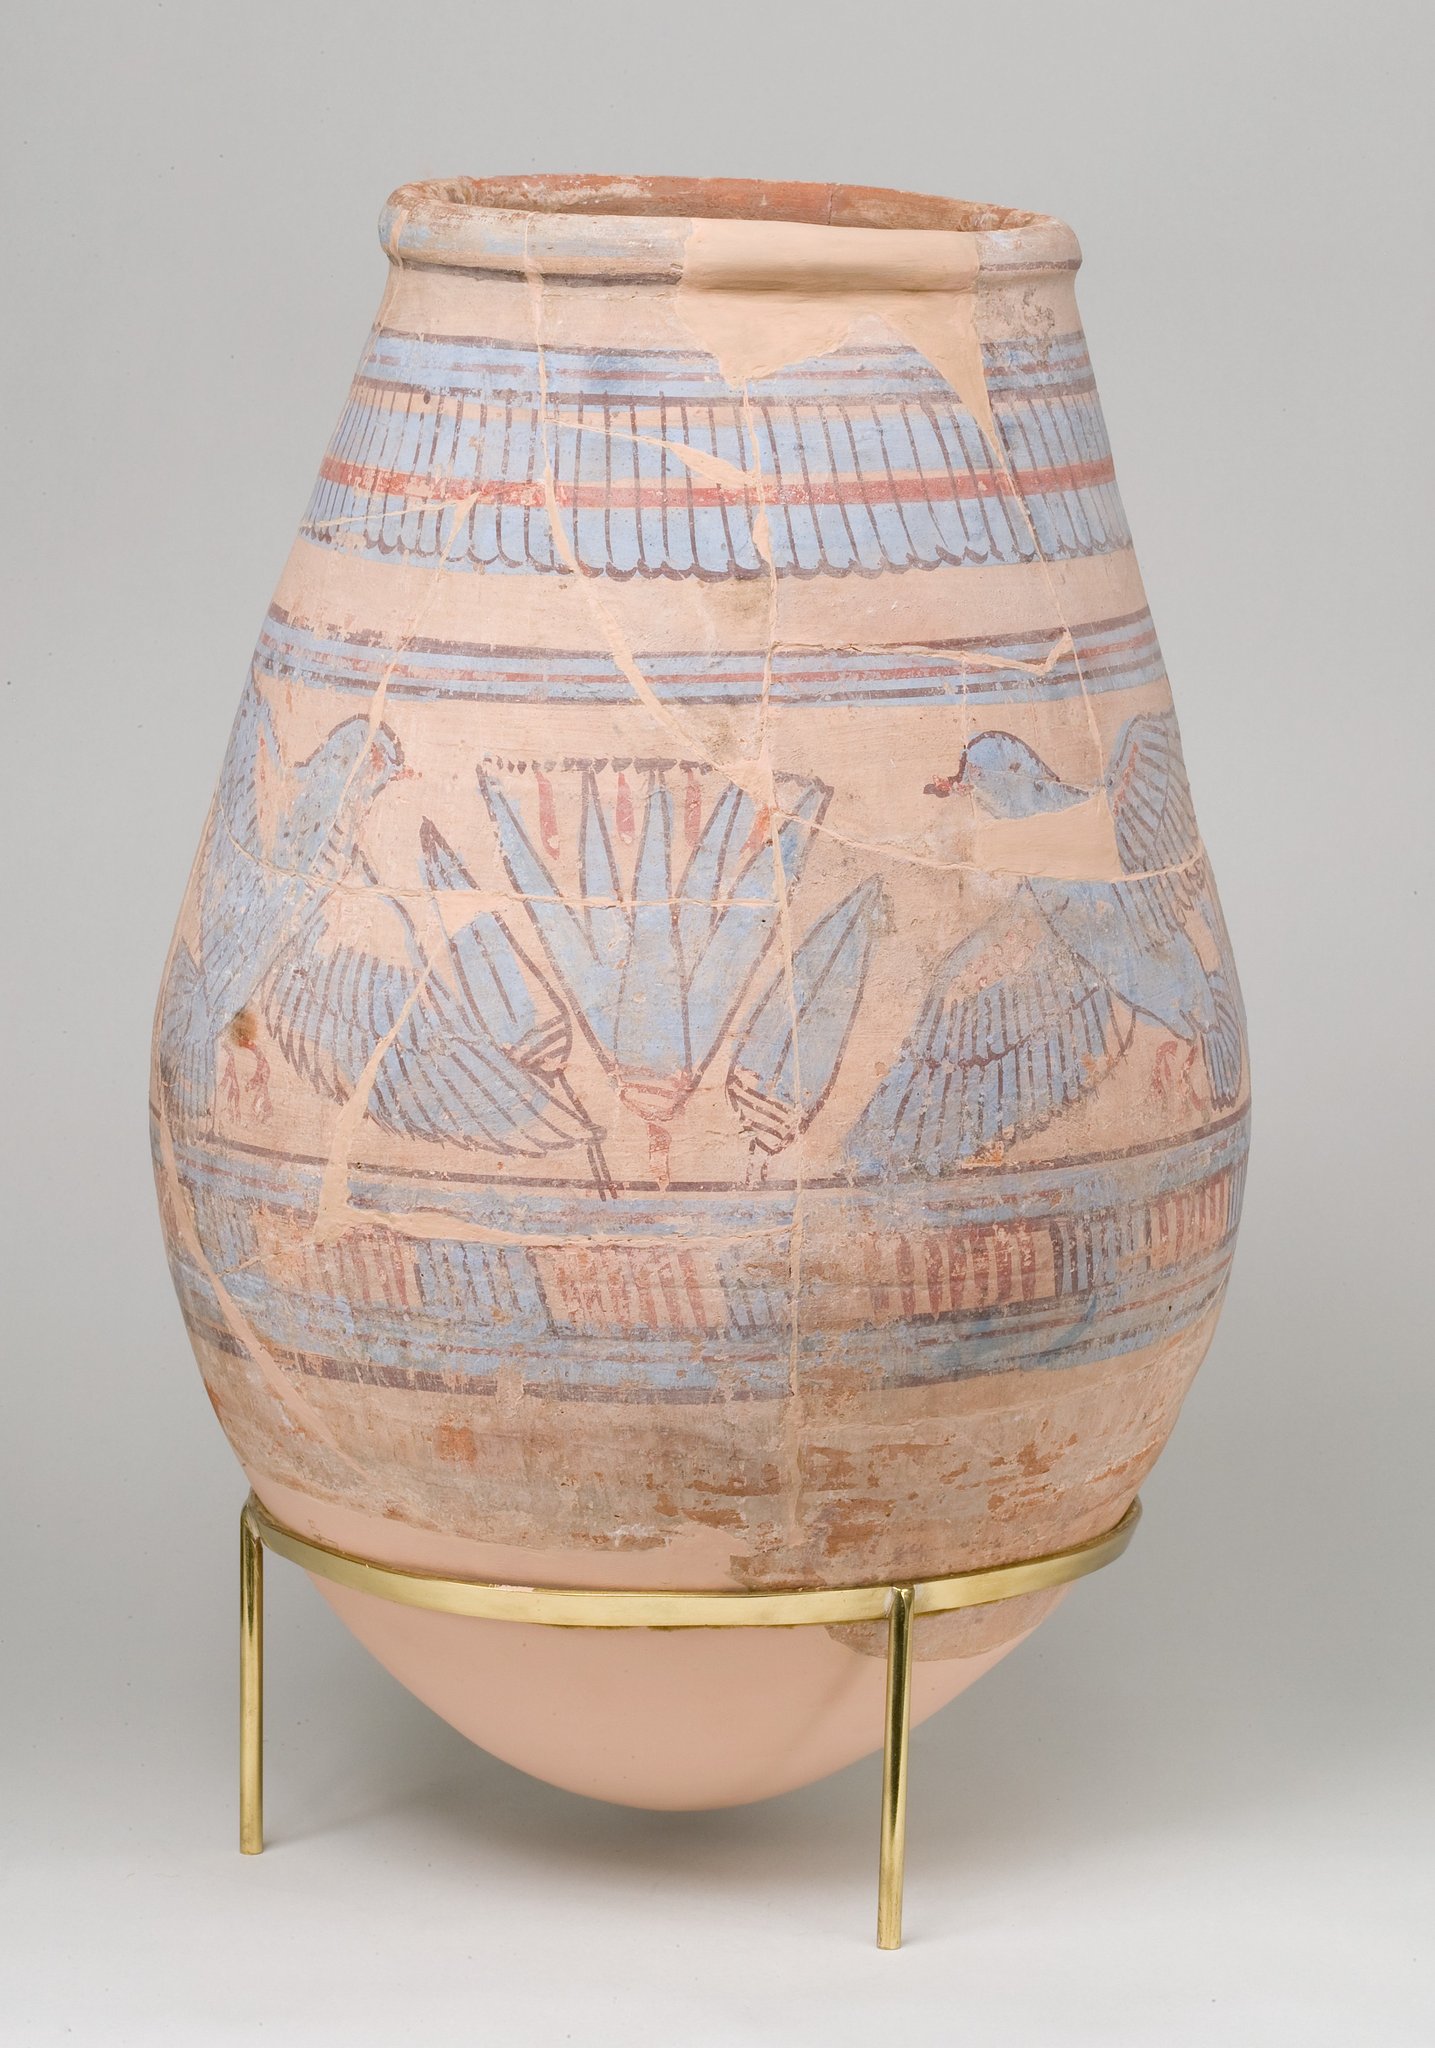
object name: jar, open mouthed, blue painted ware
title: Blue-painted Jar from Malqata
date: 1390-1352 BCE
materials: paint, pottery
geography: egypt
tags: birds